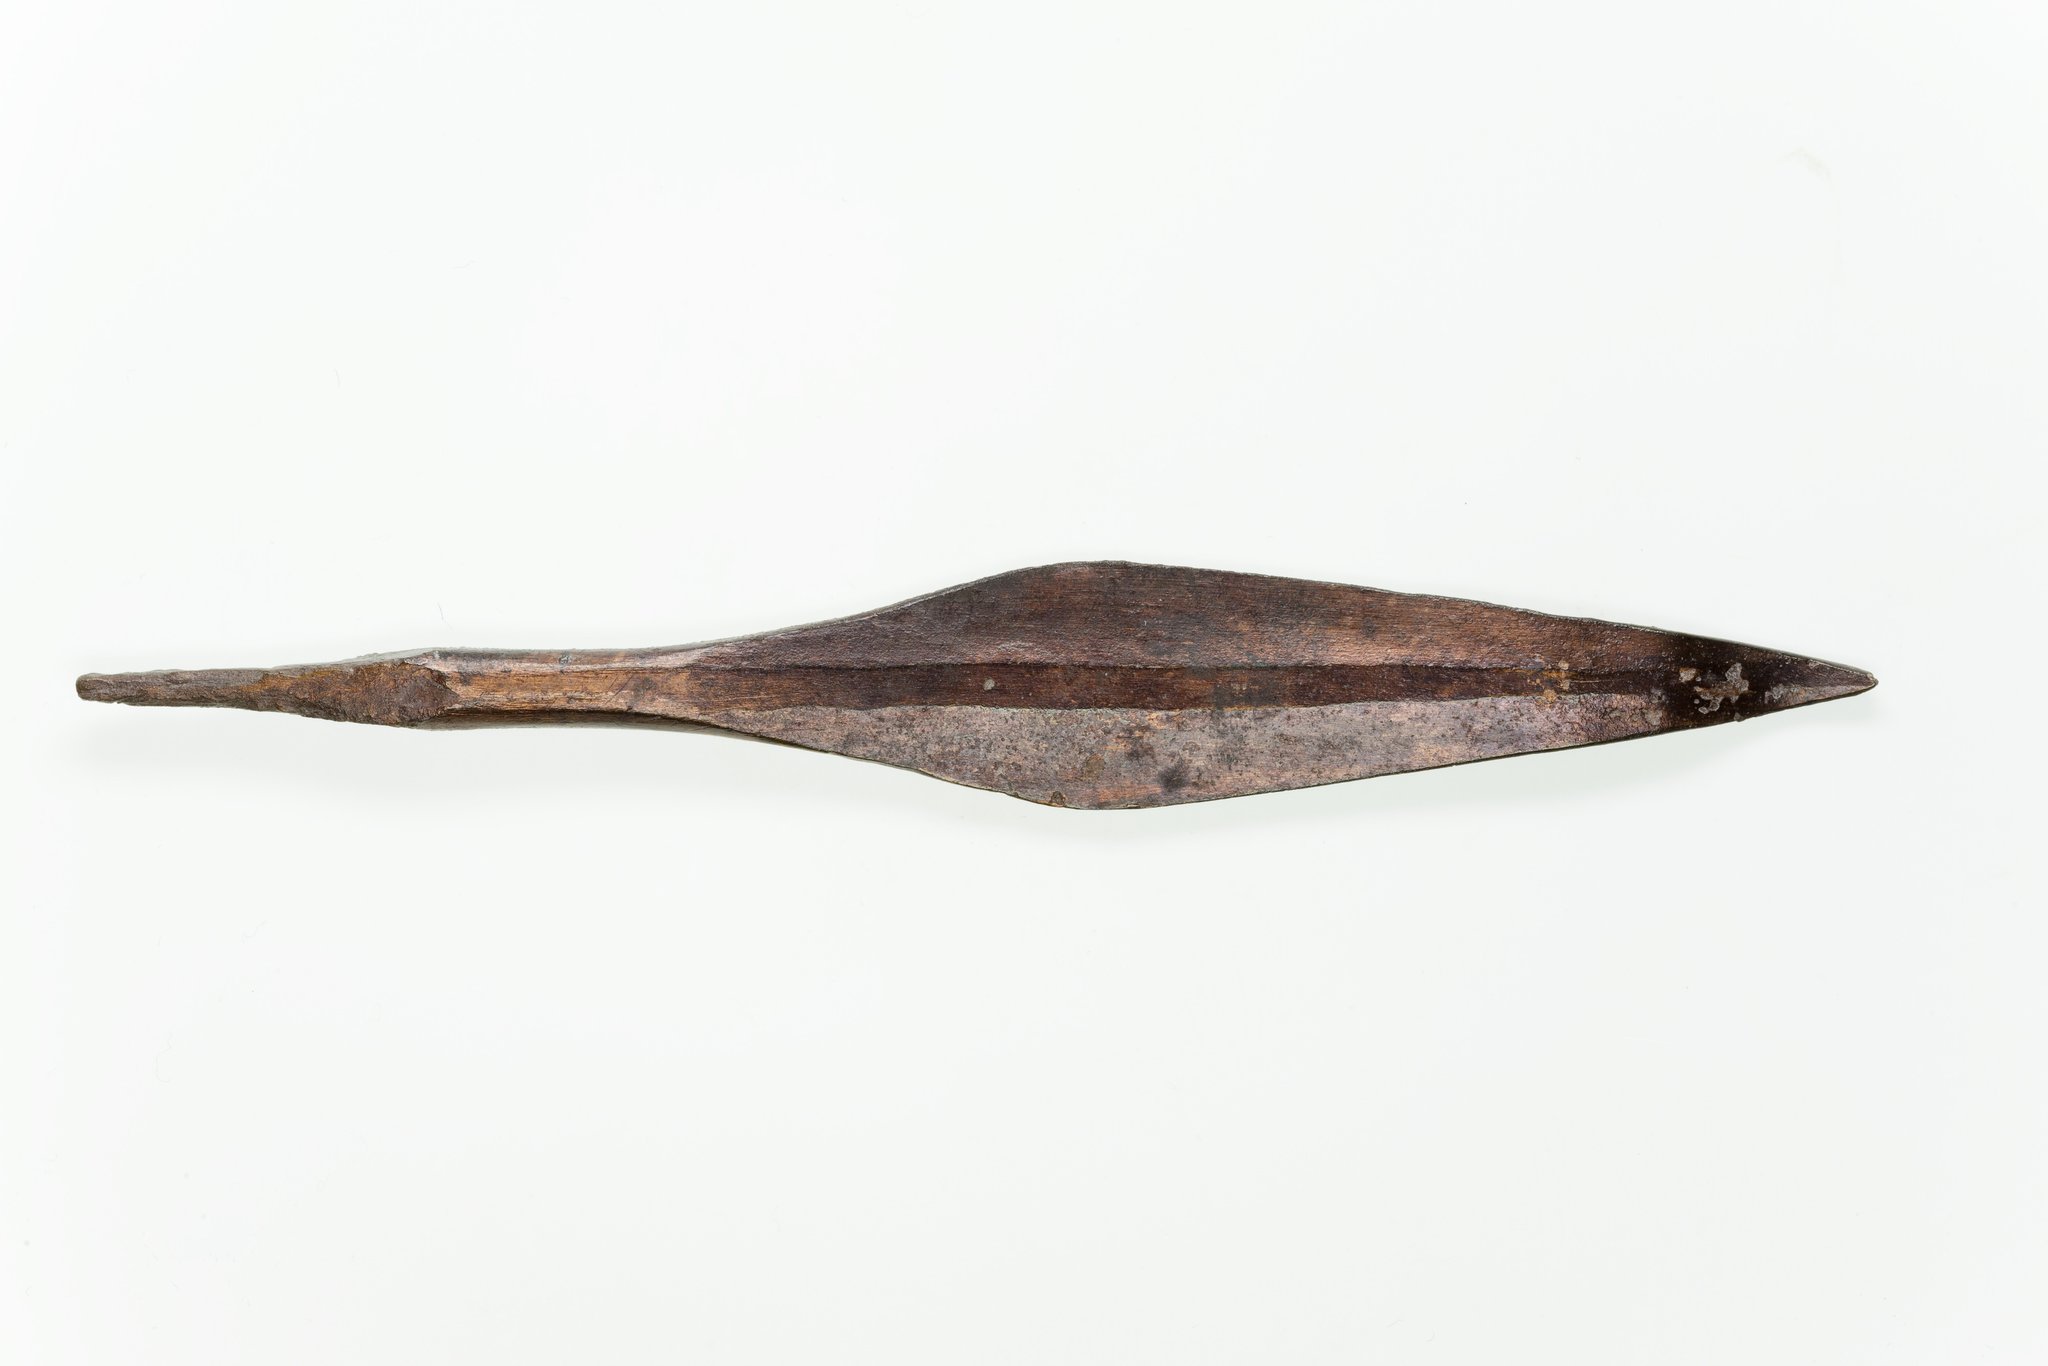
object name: arrow point, neferkhawet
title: Arrow or Javelin Point of Neferkhawet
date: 1504-1447 BCE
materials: bronze, copper alloy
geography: egypt